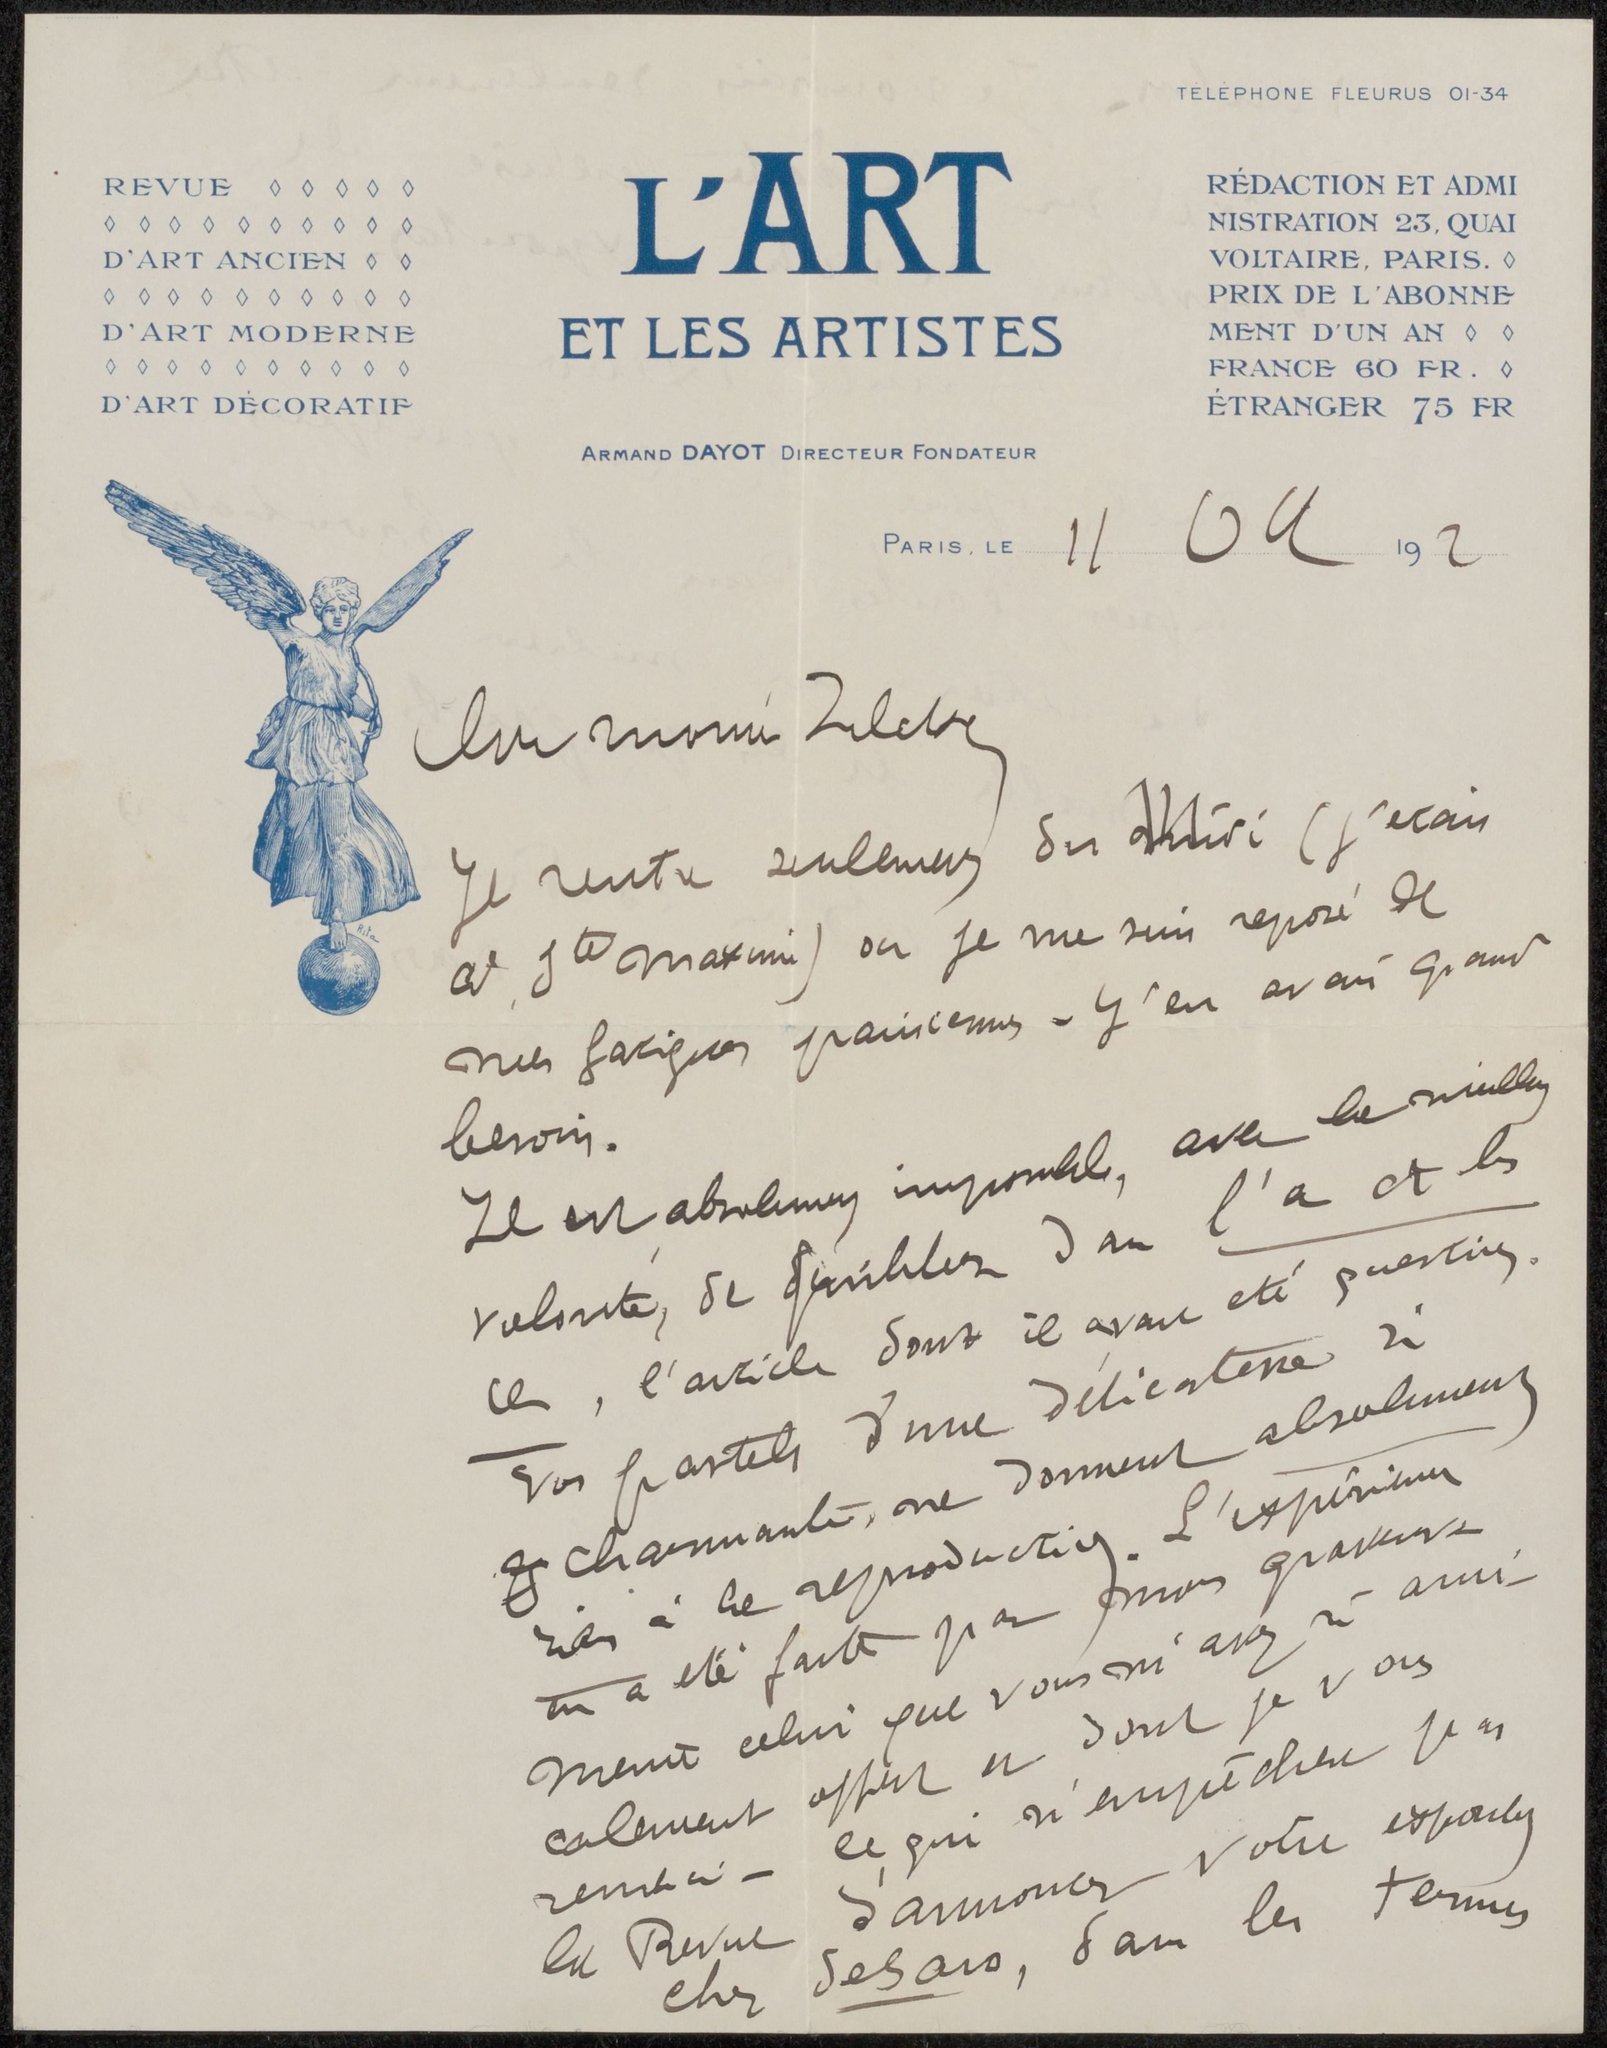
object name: letter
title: Brief aan Philip Zilcken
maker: armand dayot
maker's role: historicus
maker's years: 1851-1934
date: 1922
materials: ink, paper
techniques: pen, printing, writing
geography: paris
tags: painter, draughtsman, philip zilcken, drawing, printed matter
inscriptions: collector's mark: ‘RPK’